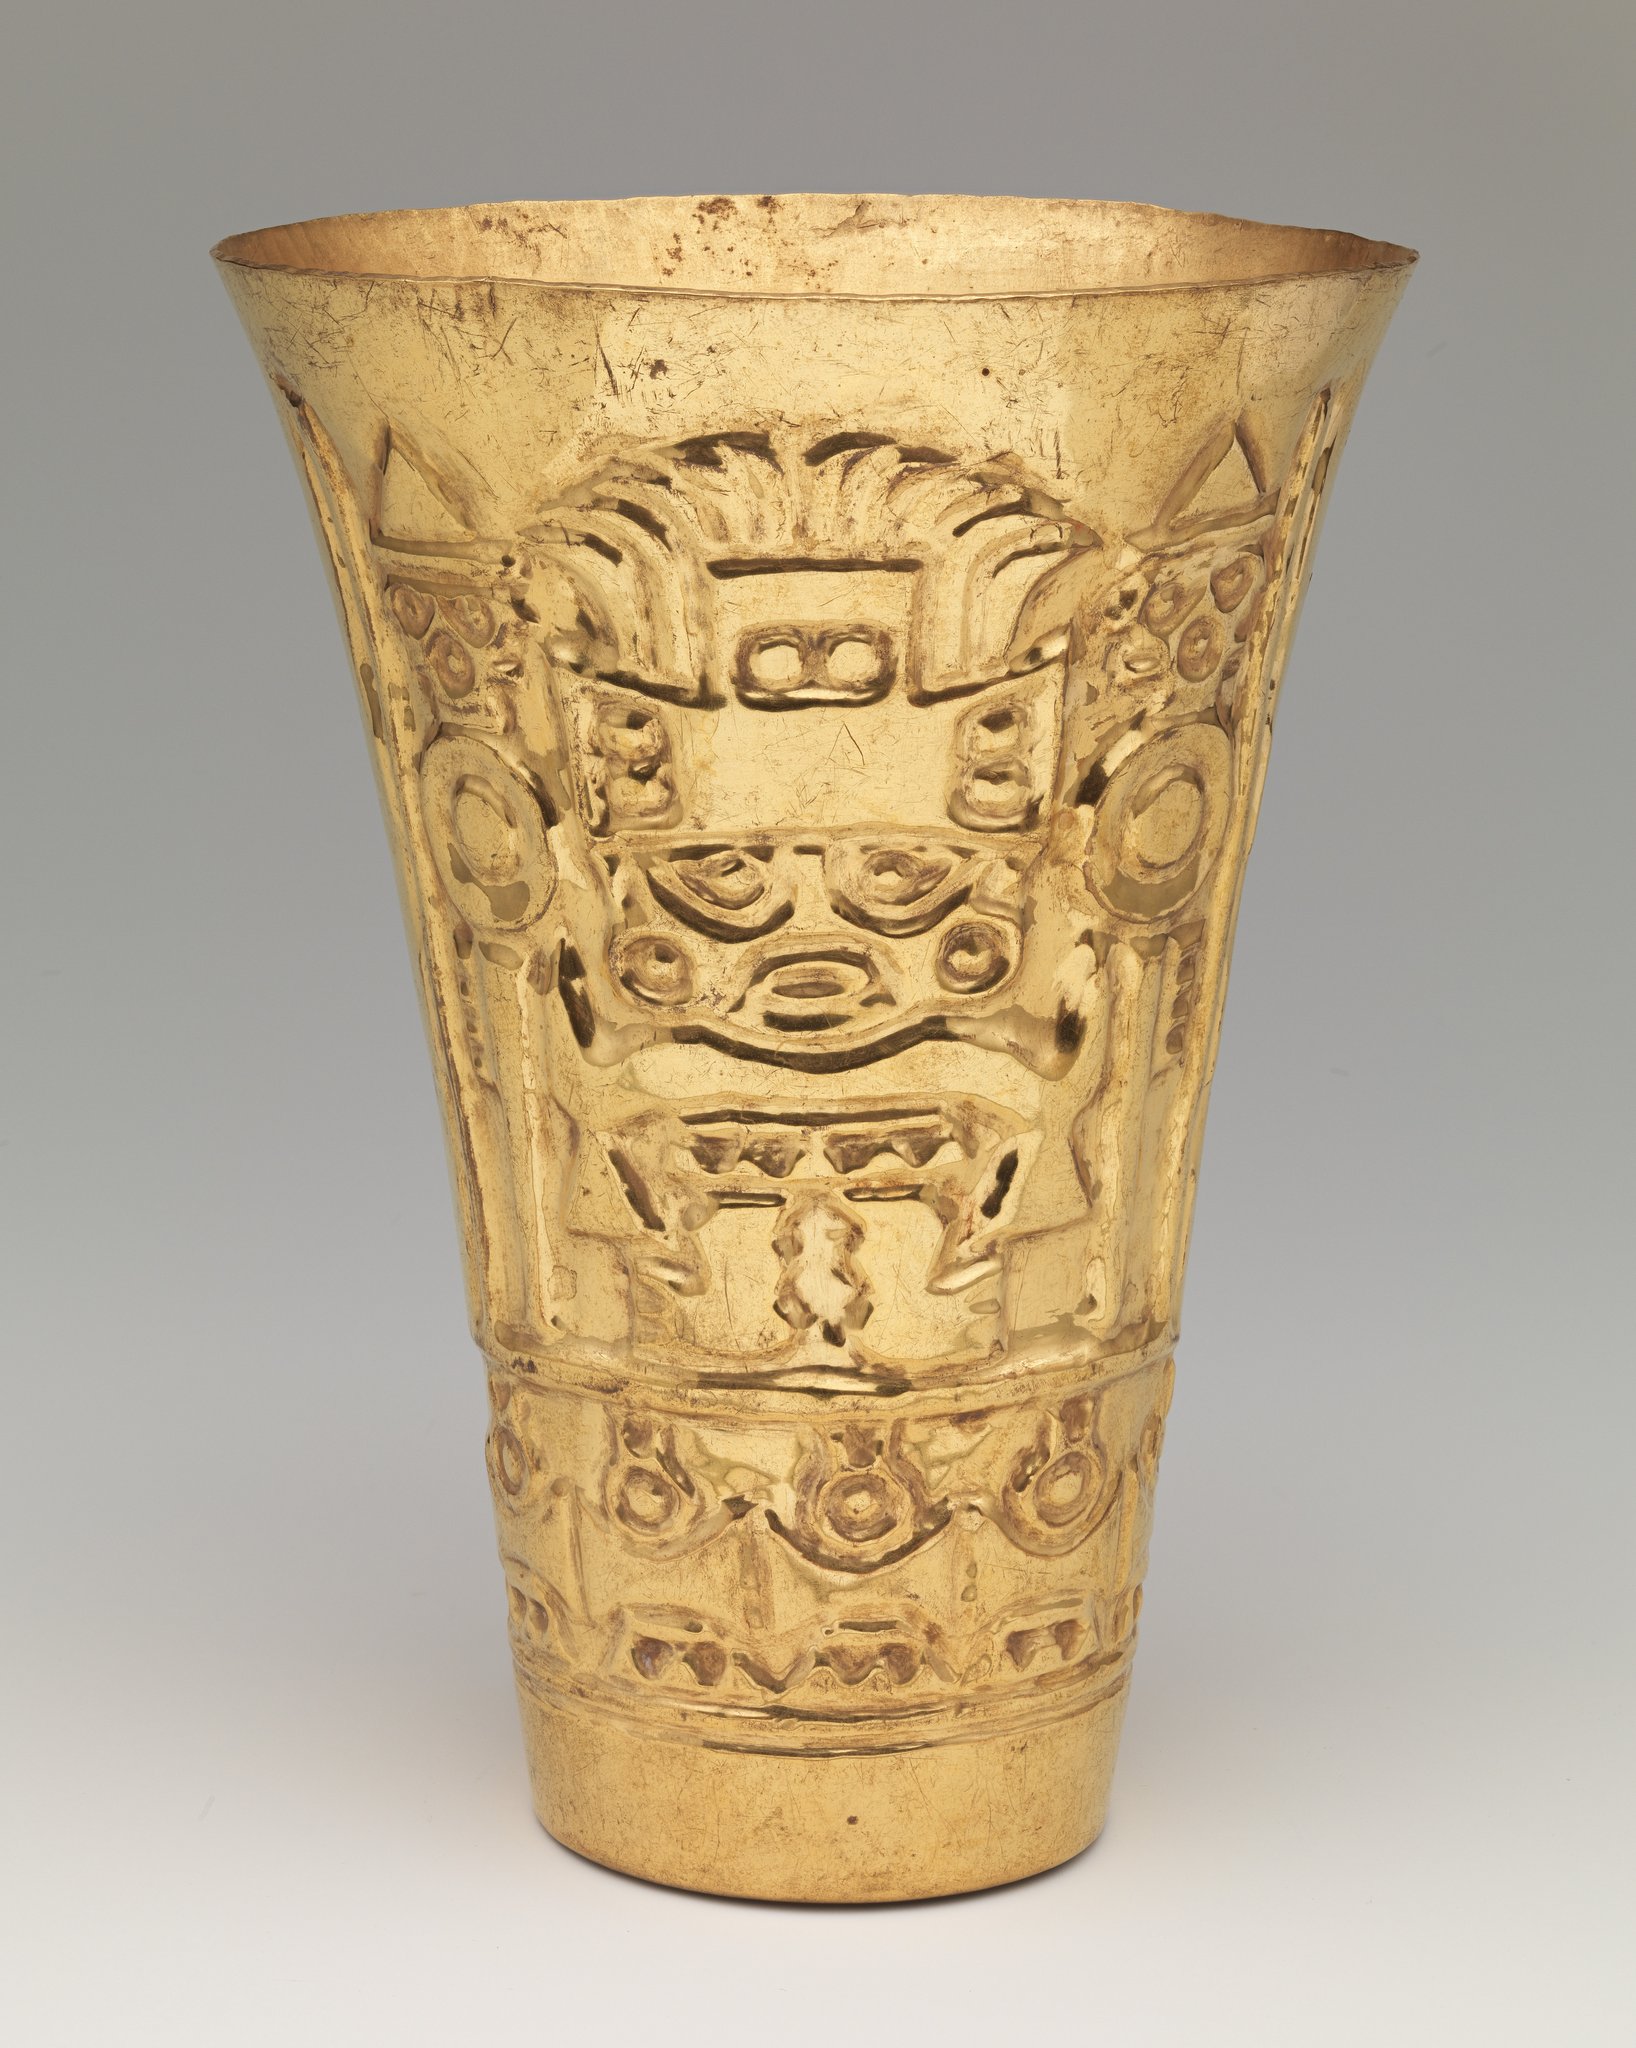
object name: beaker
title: Beaker with frontal figure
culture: lambayeque, sicán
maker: lambayeque (sicán) artist(s)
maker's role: artist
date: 900-1100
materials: gold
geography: peru